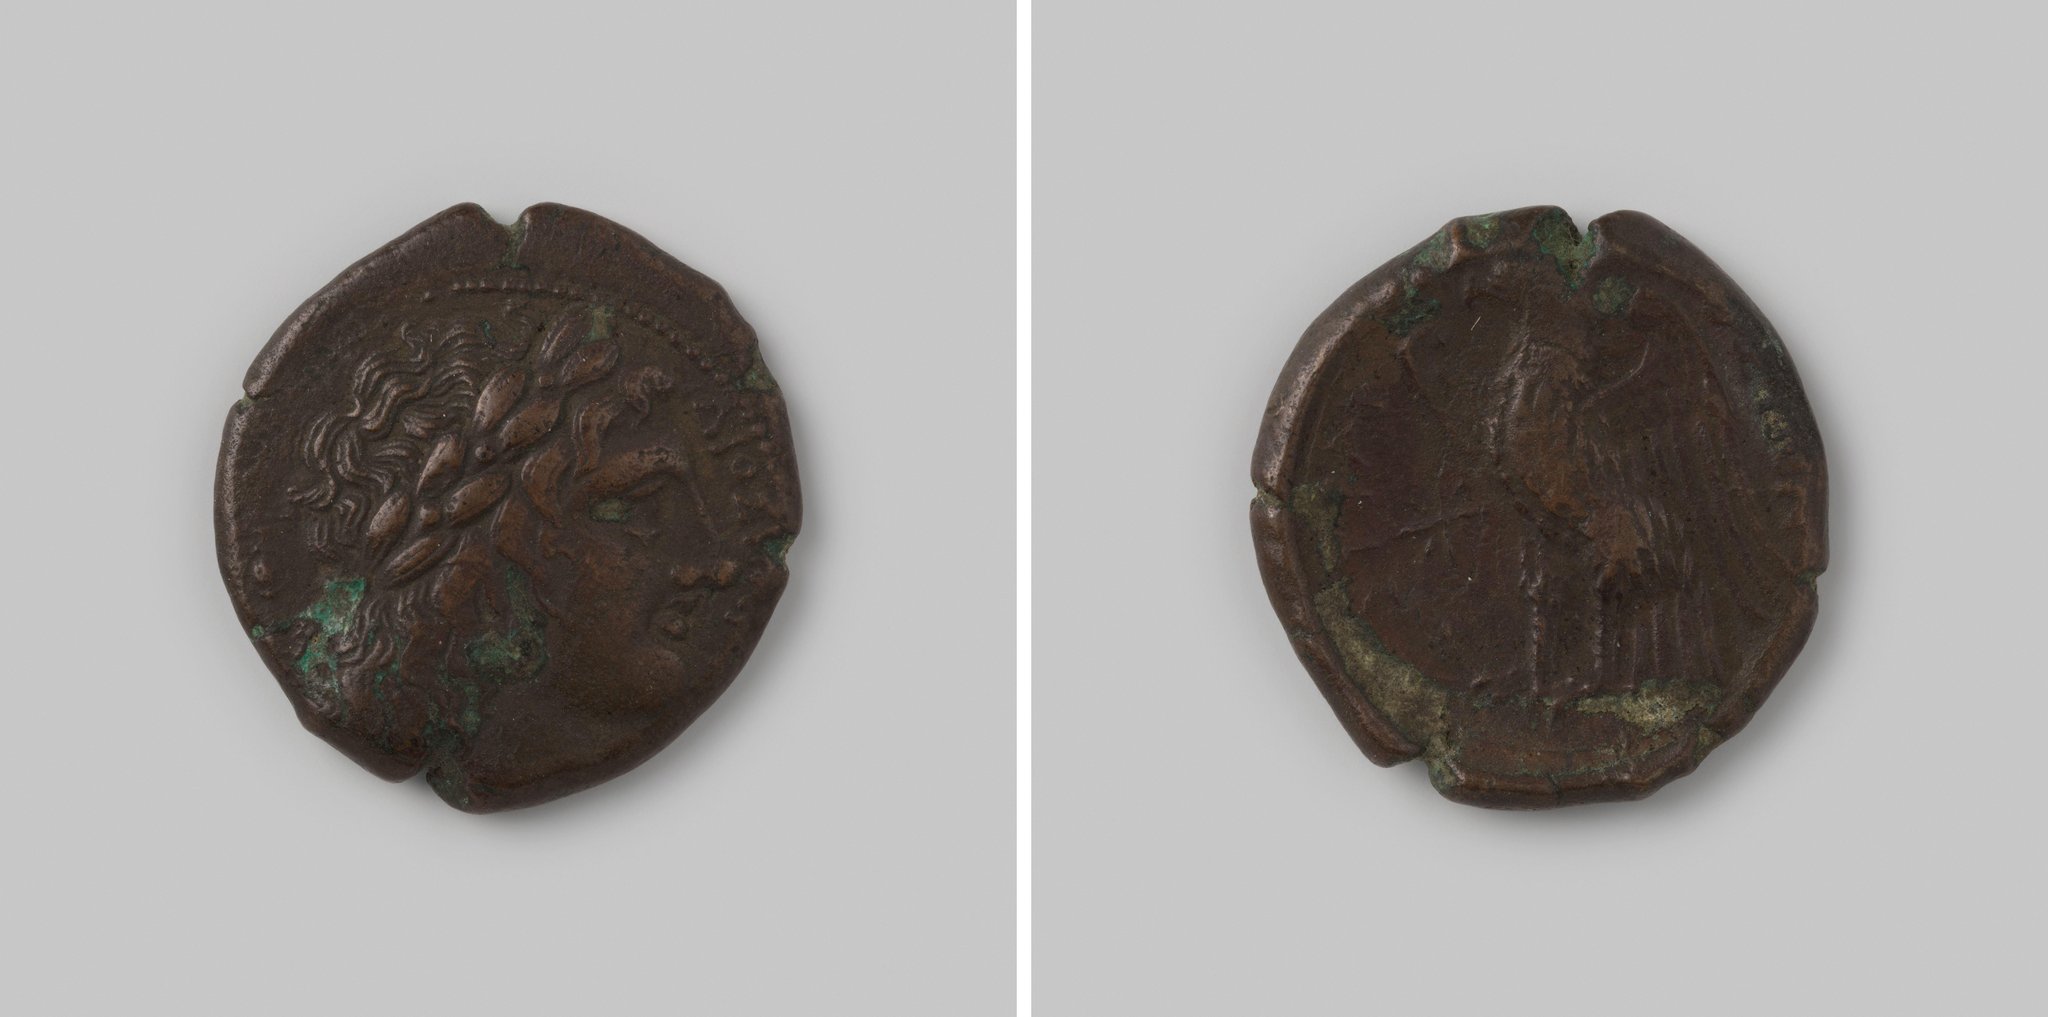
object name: coin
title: Obool [?] uit de Griekse koloniën in Italië van Syracuse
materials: bronze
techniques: striking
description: Bronzen munt. Voorzijde: gelauwerd hoofd van Jupiter naar rechts. Keerzijde: adelaar met gesp[reide vleugels op een bliksem van links. In het veld een ster.